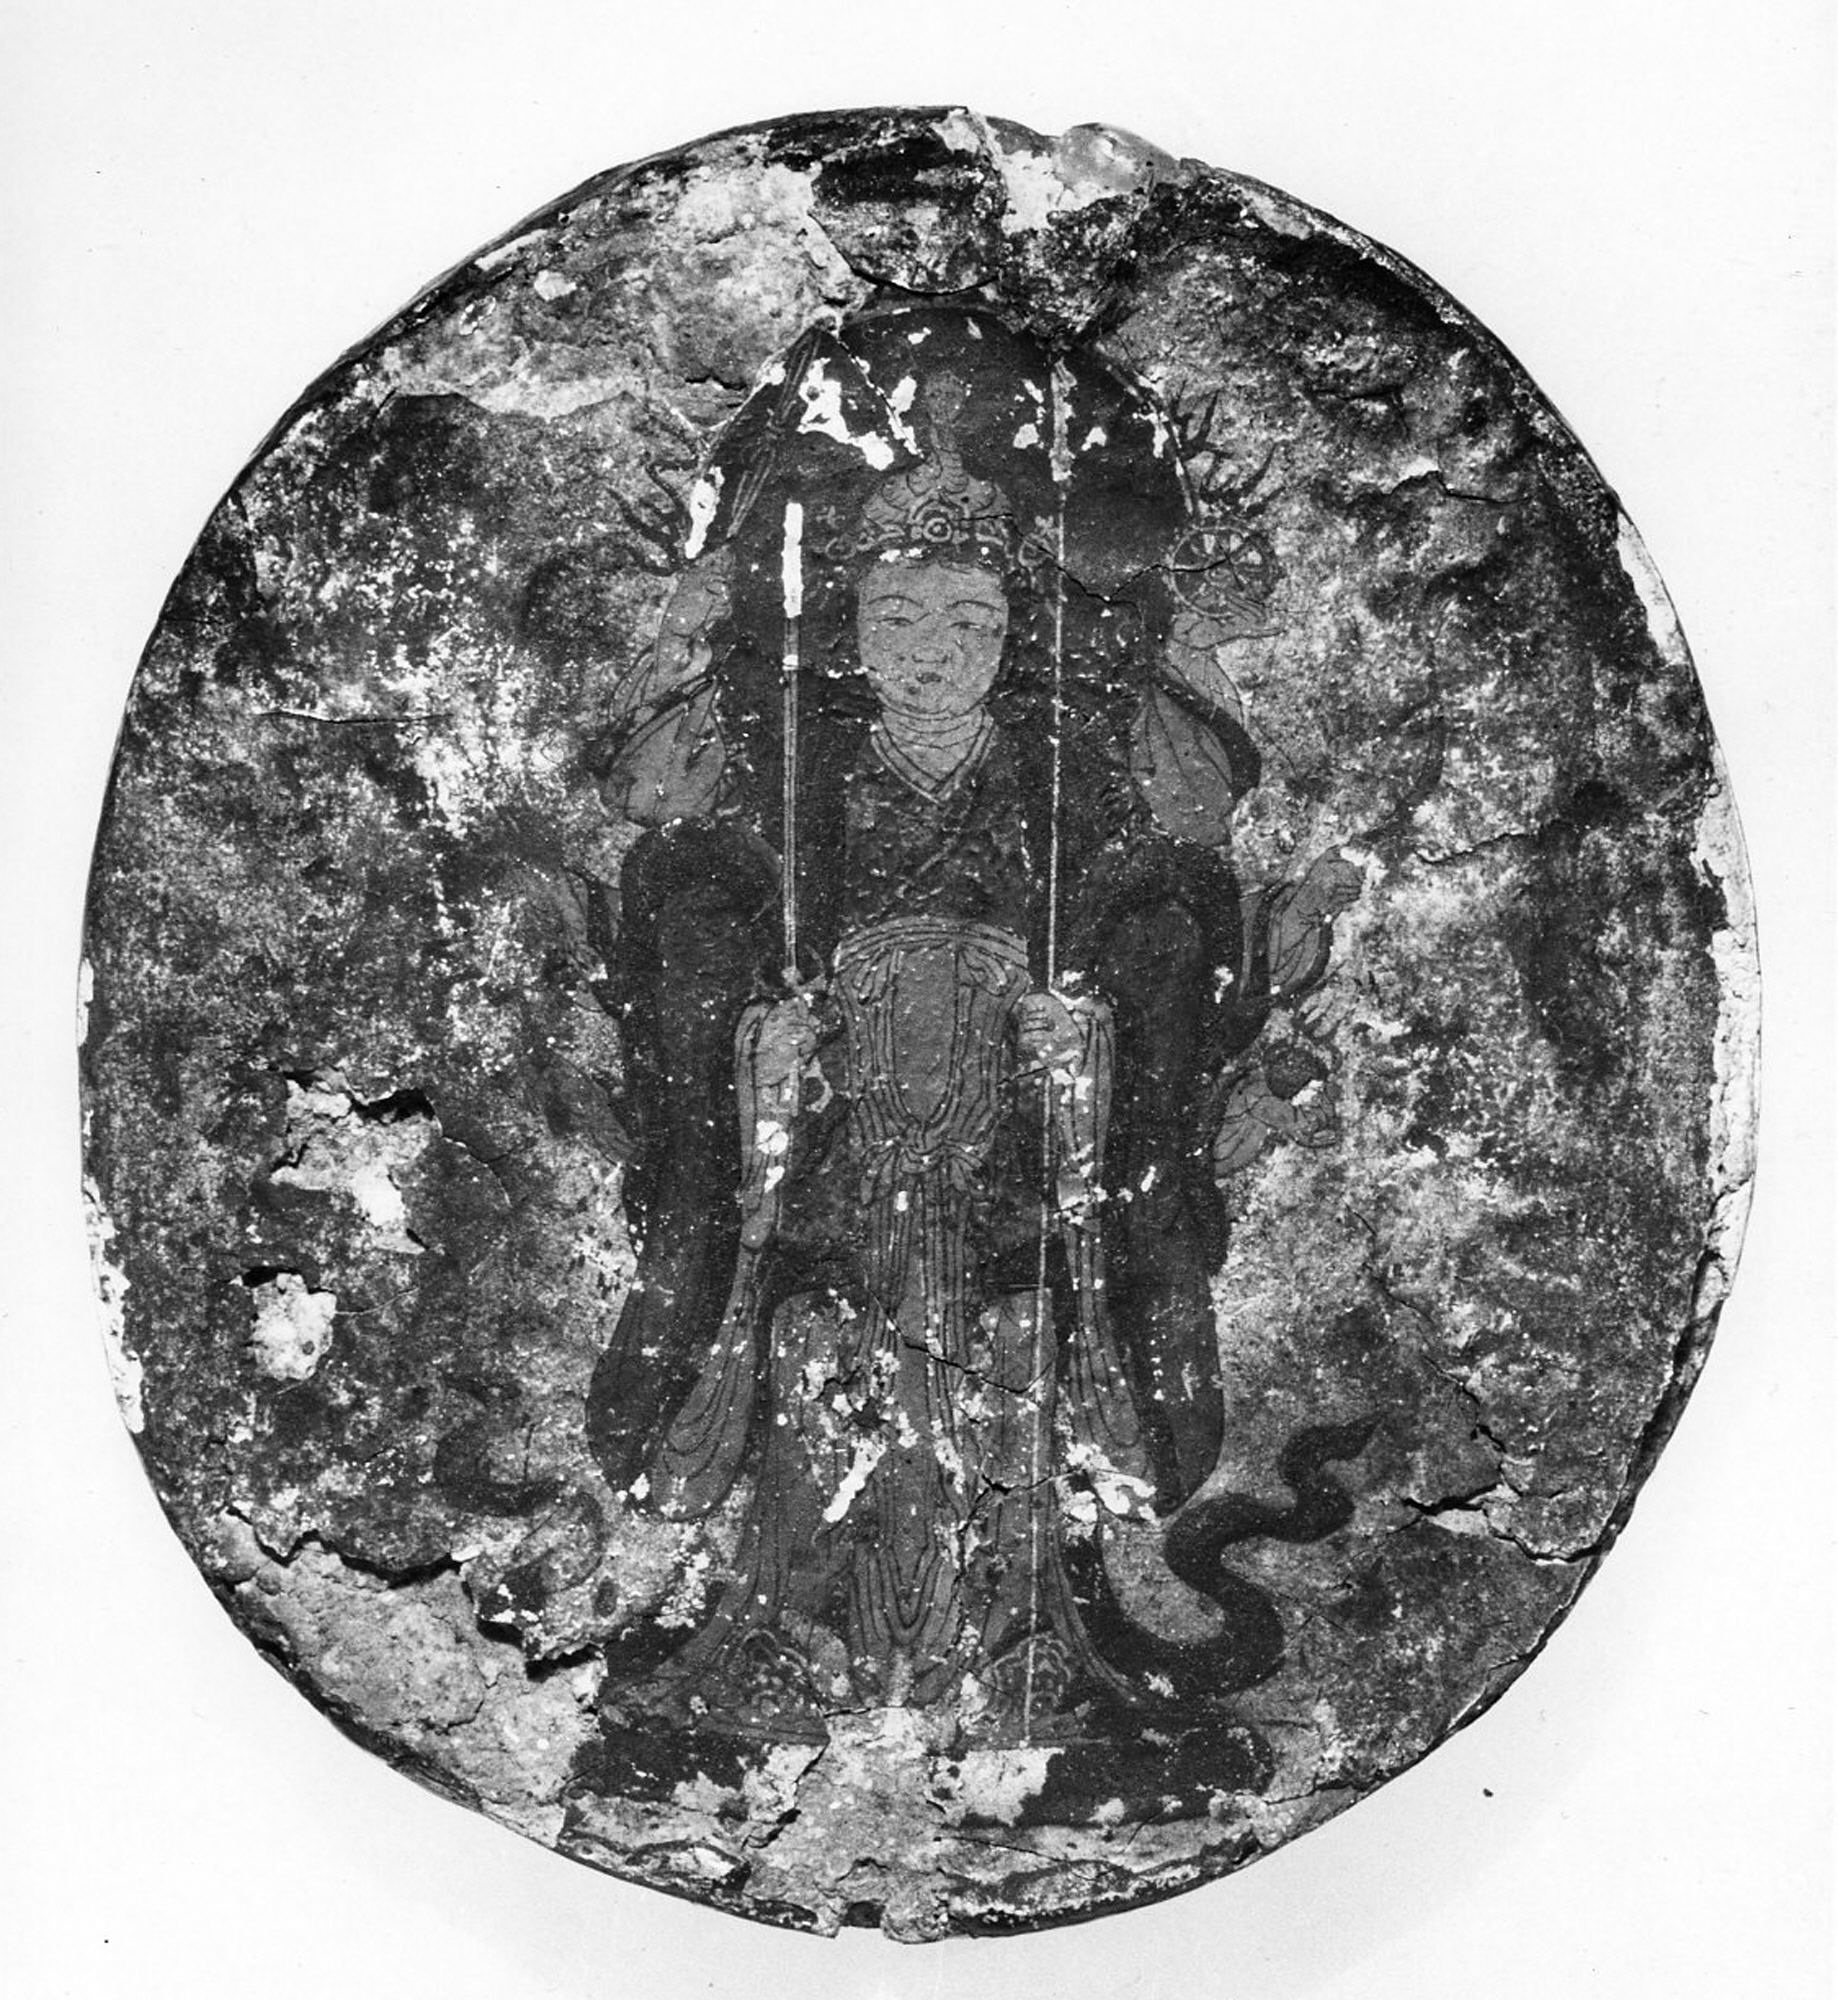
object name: disk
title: Benzaiten and Ugajin (Japanese Rice Deity)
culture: japanese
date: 1615-1868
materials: clay, gold, lacquer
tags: deities